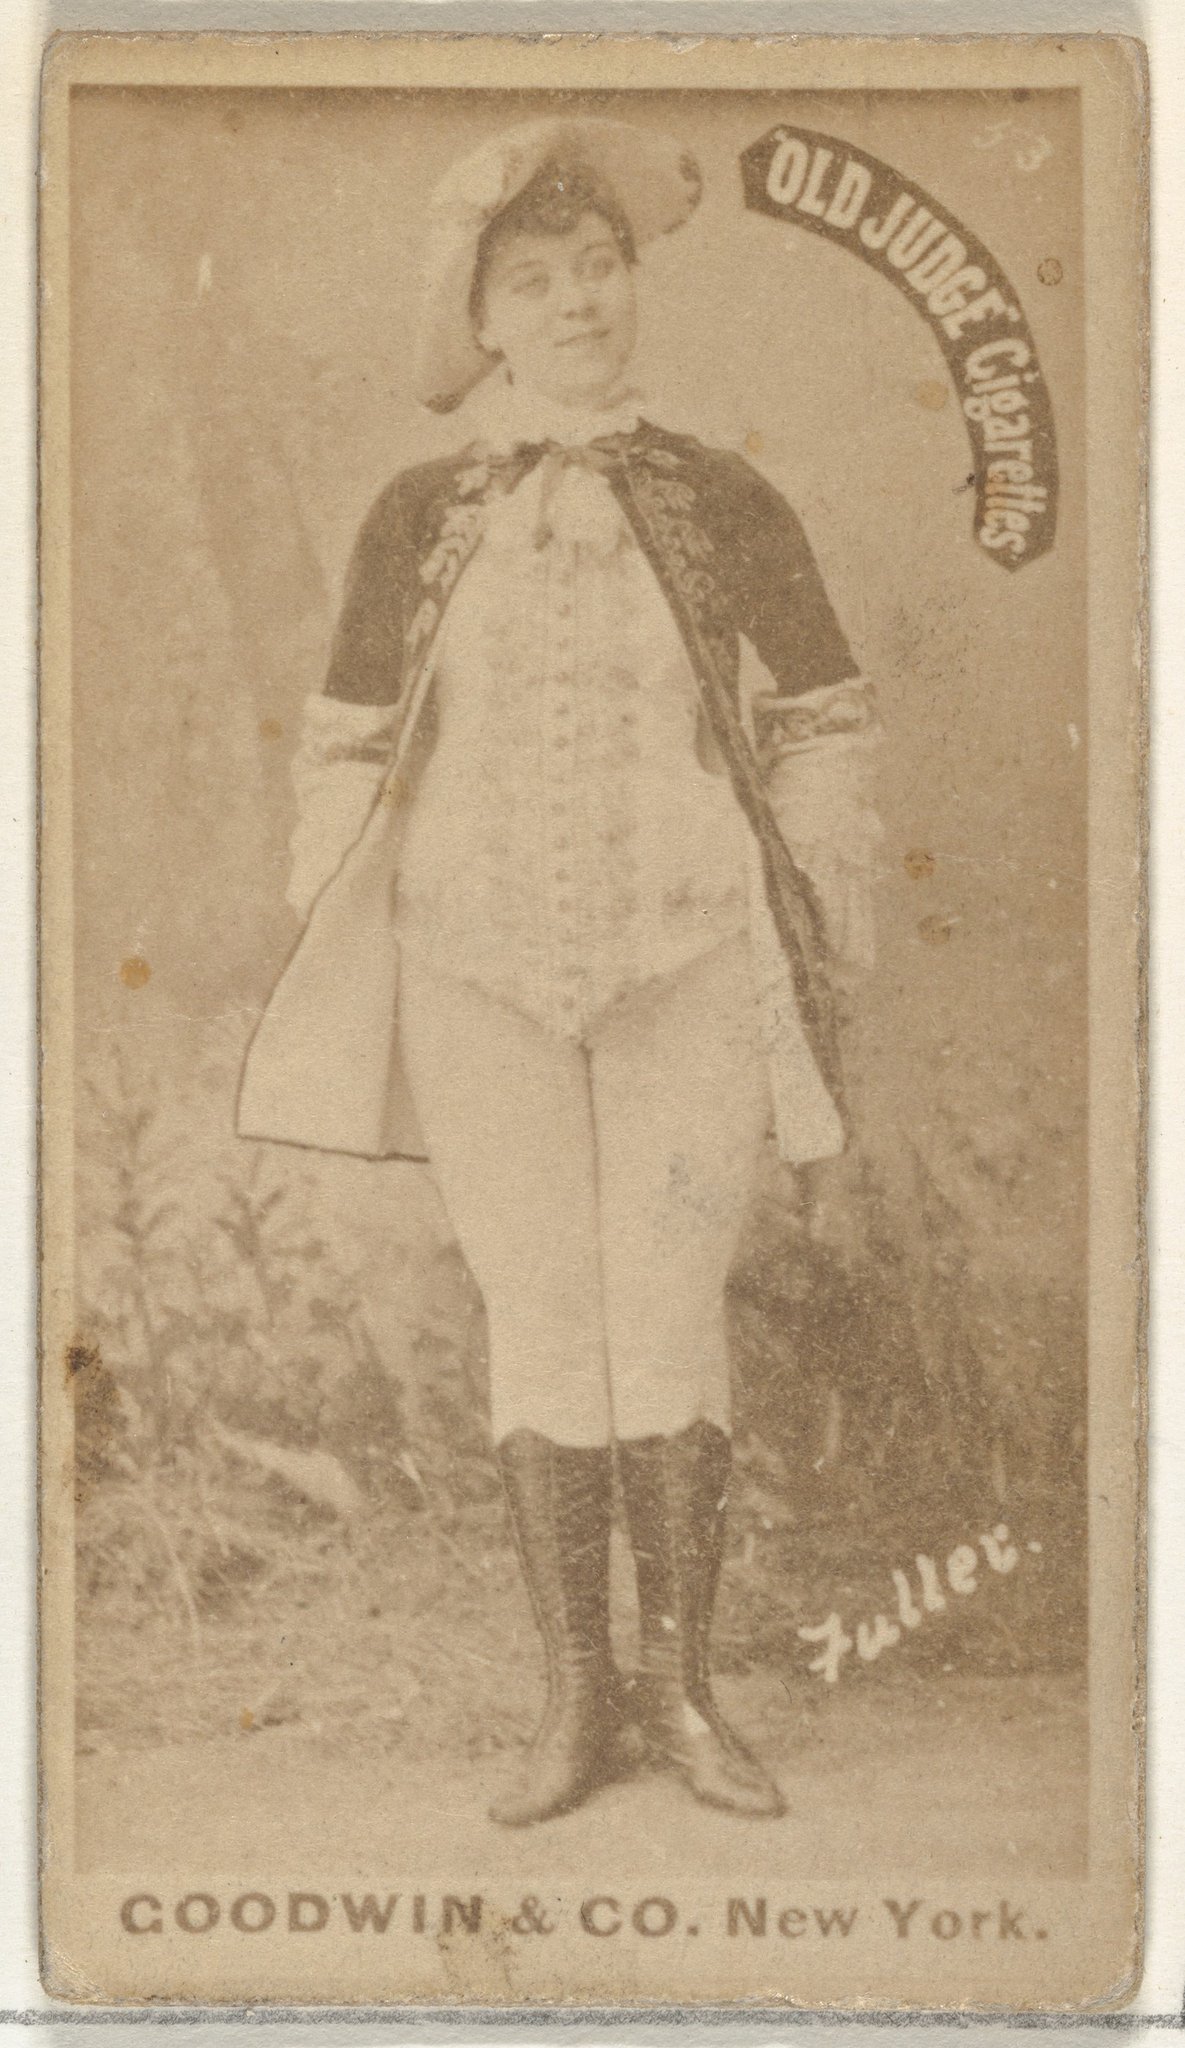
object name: photograph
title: Fuller, from the Actors and Actresses series (N171) for Old Judge Cigarettes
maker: goodwin & company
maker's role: publisher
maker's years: 1850-1950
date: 1886-1890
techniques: albumen silver print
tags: portraits,women,actresses